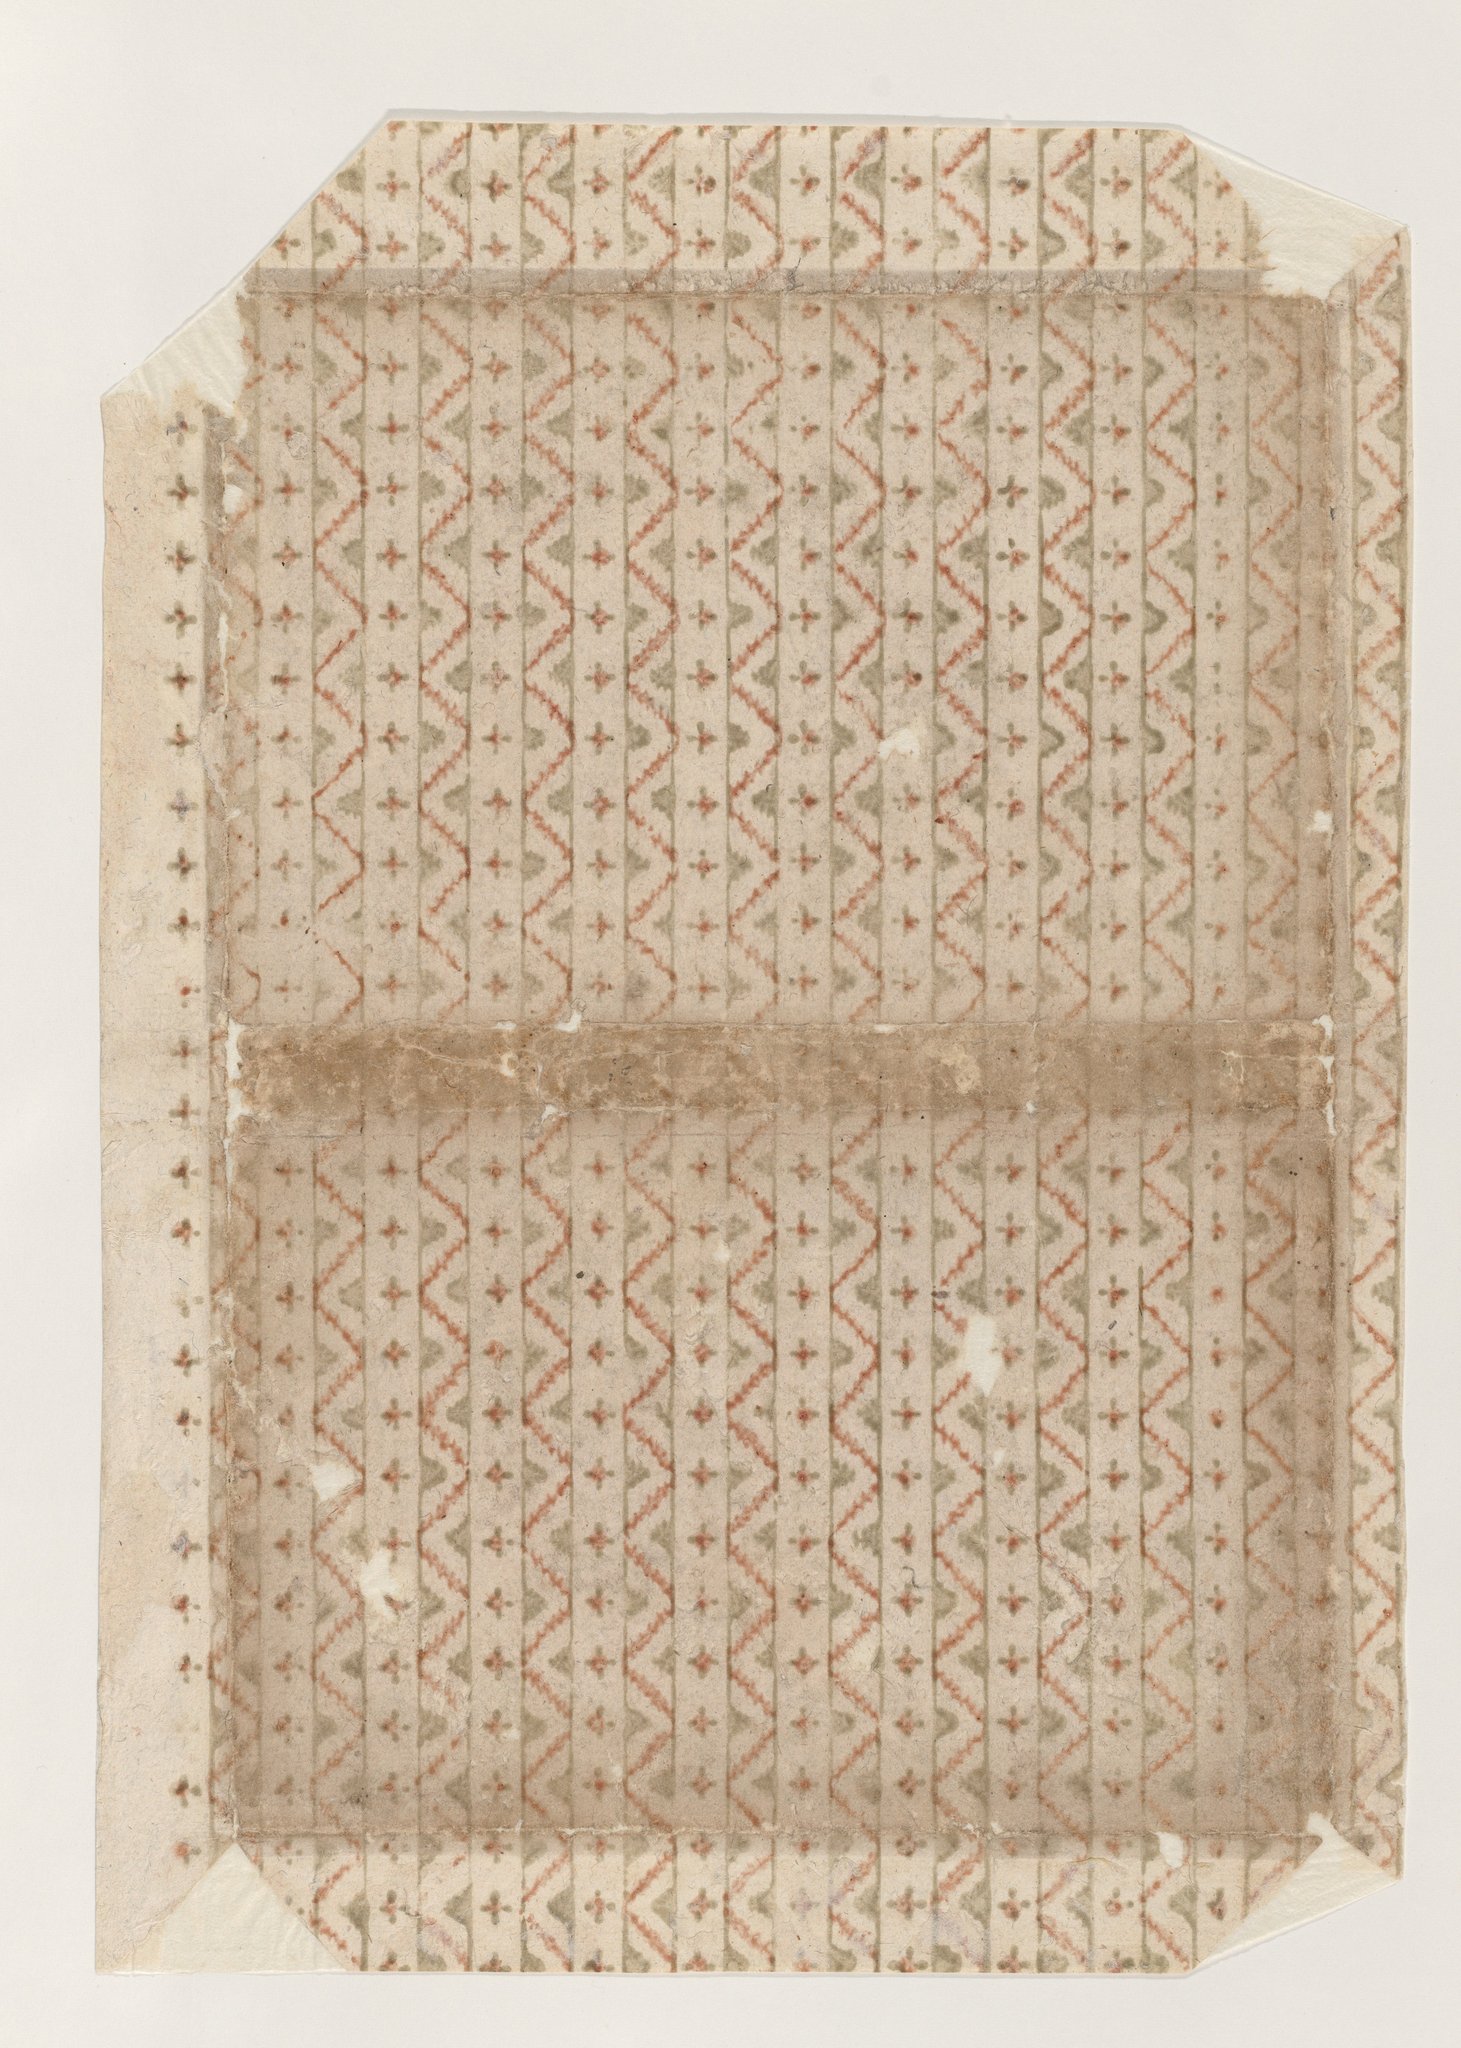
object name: print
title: Book cover with overall zigzag pattern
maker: Anonymous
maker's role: artist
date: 1801-1900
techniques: relief print